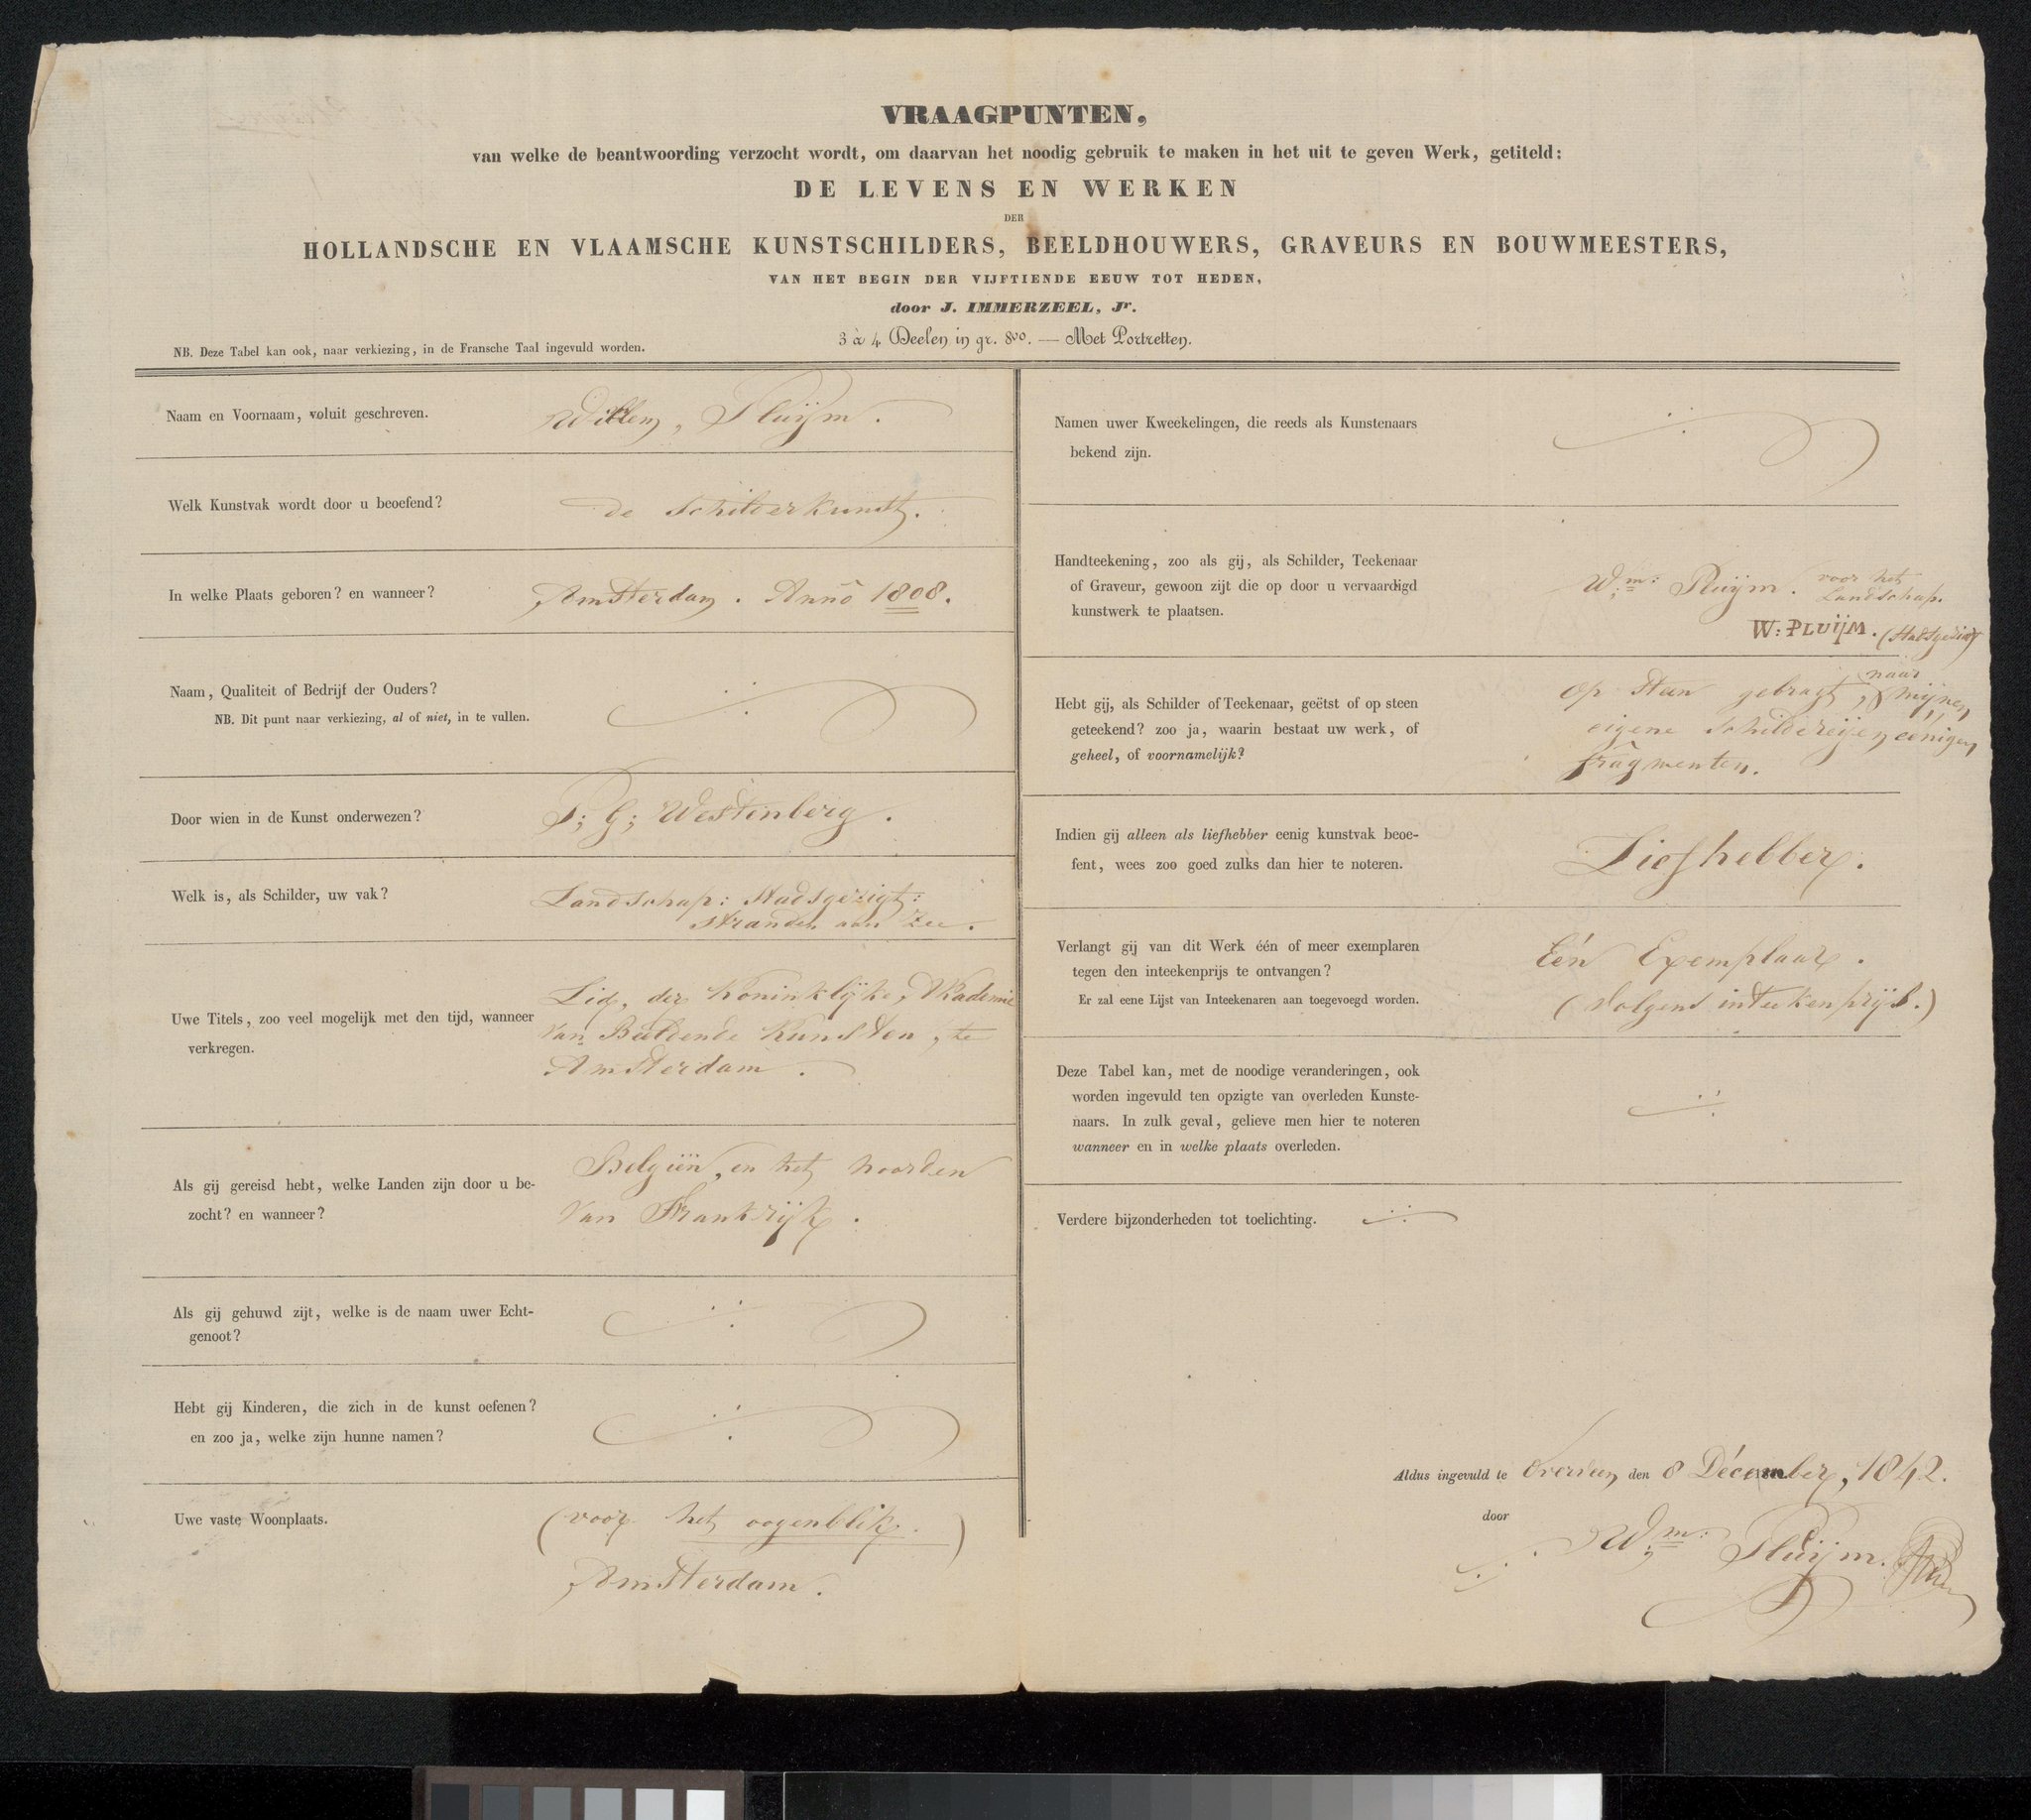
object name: manuscript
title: Enquêteformulier ingevuld door Willem Pluijm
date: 1842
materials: ink, paper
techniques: pen, printing, writing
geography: overveen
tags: amsterdam, print maker, willem pluijm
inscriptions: watermark, inscription: ‘Vraagpunten,/ van welke de beantwoording verzocht wordt, om daarvan het noodig gebruik te maken in het uit te geven Werk, getiteld: De levens en werken/ der Hollandsche en Vlaamsche kunstschilders, beeldhouwers,/ graveurs en bouwmeesters, van het begin der vijftiende eeuw tot heden/ door J. Immerzeel, Jr.’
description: Opgenomen in: Immerzeel, J. Jr., De levens en werken der Hollandsche en Vlaamsche kunstschilders, beeldhouwers, graveurs en bouwmeesters, van het begin der vijftiende eeuw tot heden, Amsterdam: J.C. van Kesteren, 1842-1843.